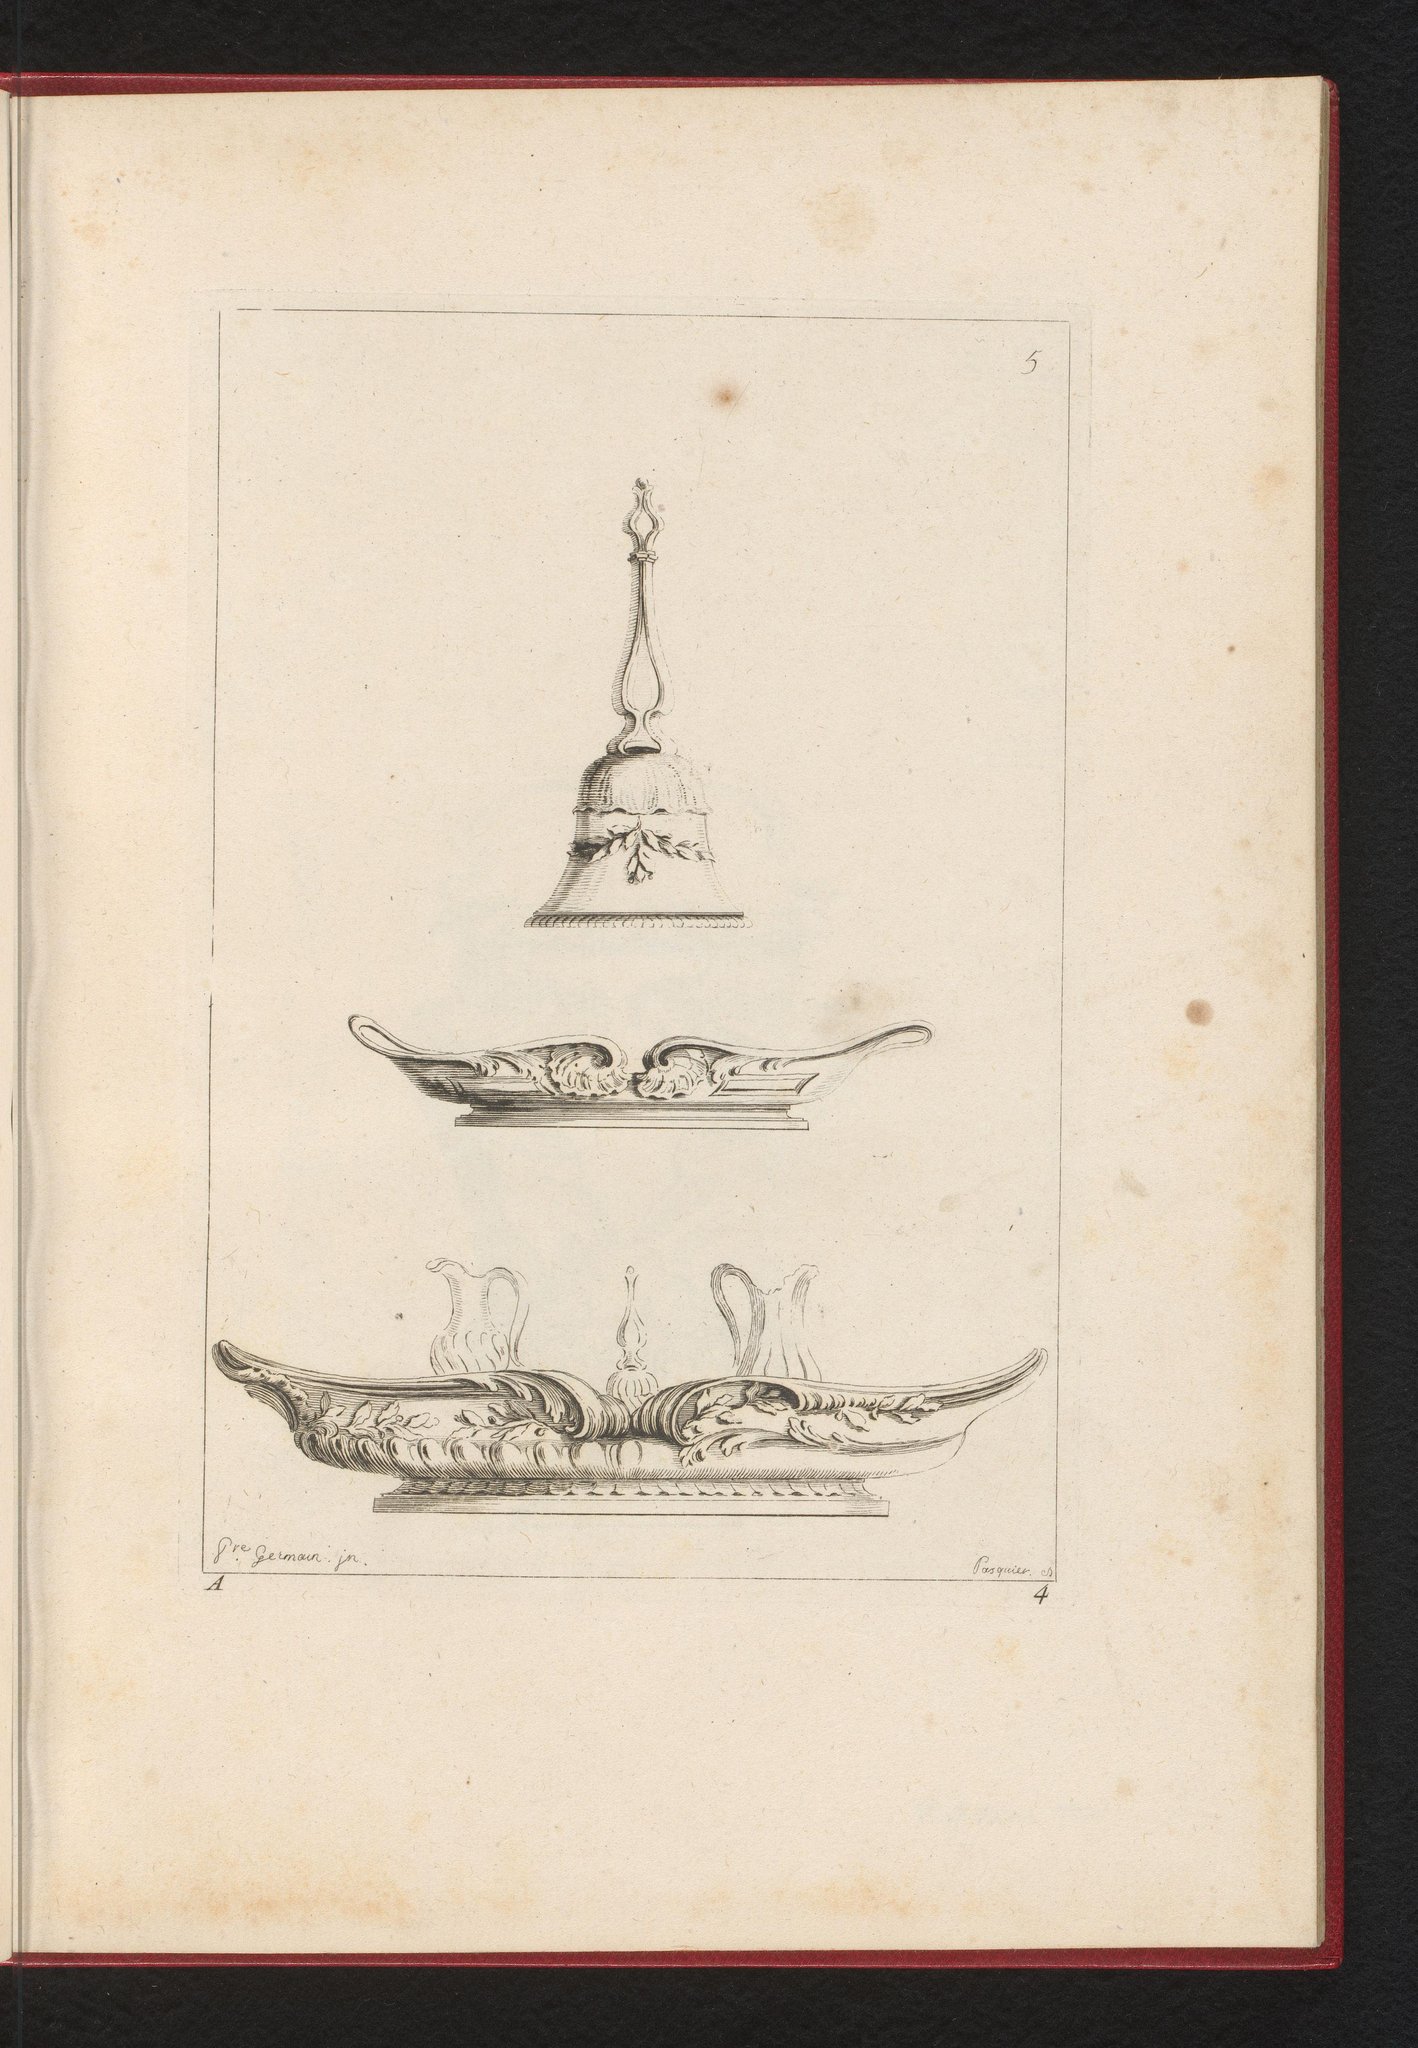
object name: print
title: Elements d'orfevrerie divisés en deux parties de cinquante feuilles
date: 1748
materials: paper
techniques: etching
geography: paris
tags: ornaments ~ art, jug and basin; wash-basin, cruets and basin ~ communion ware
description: Een aantal van de objecten in deze reeks heeft een eigen ondertitel, die verwijst naar genummerde 'cahiers' (afleveringen) waarin de prenten werden uitgegeven. Het is onduidelijk welke objecten recies bij welke aflevering horen. Daarom is die ondertitel enkel verwerkt bij de prent waarop die voorkomt.